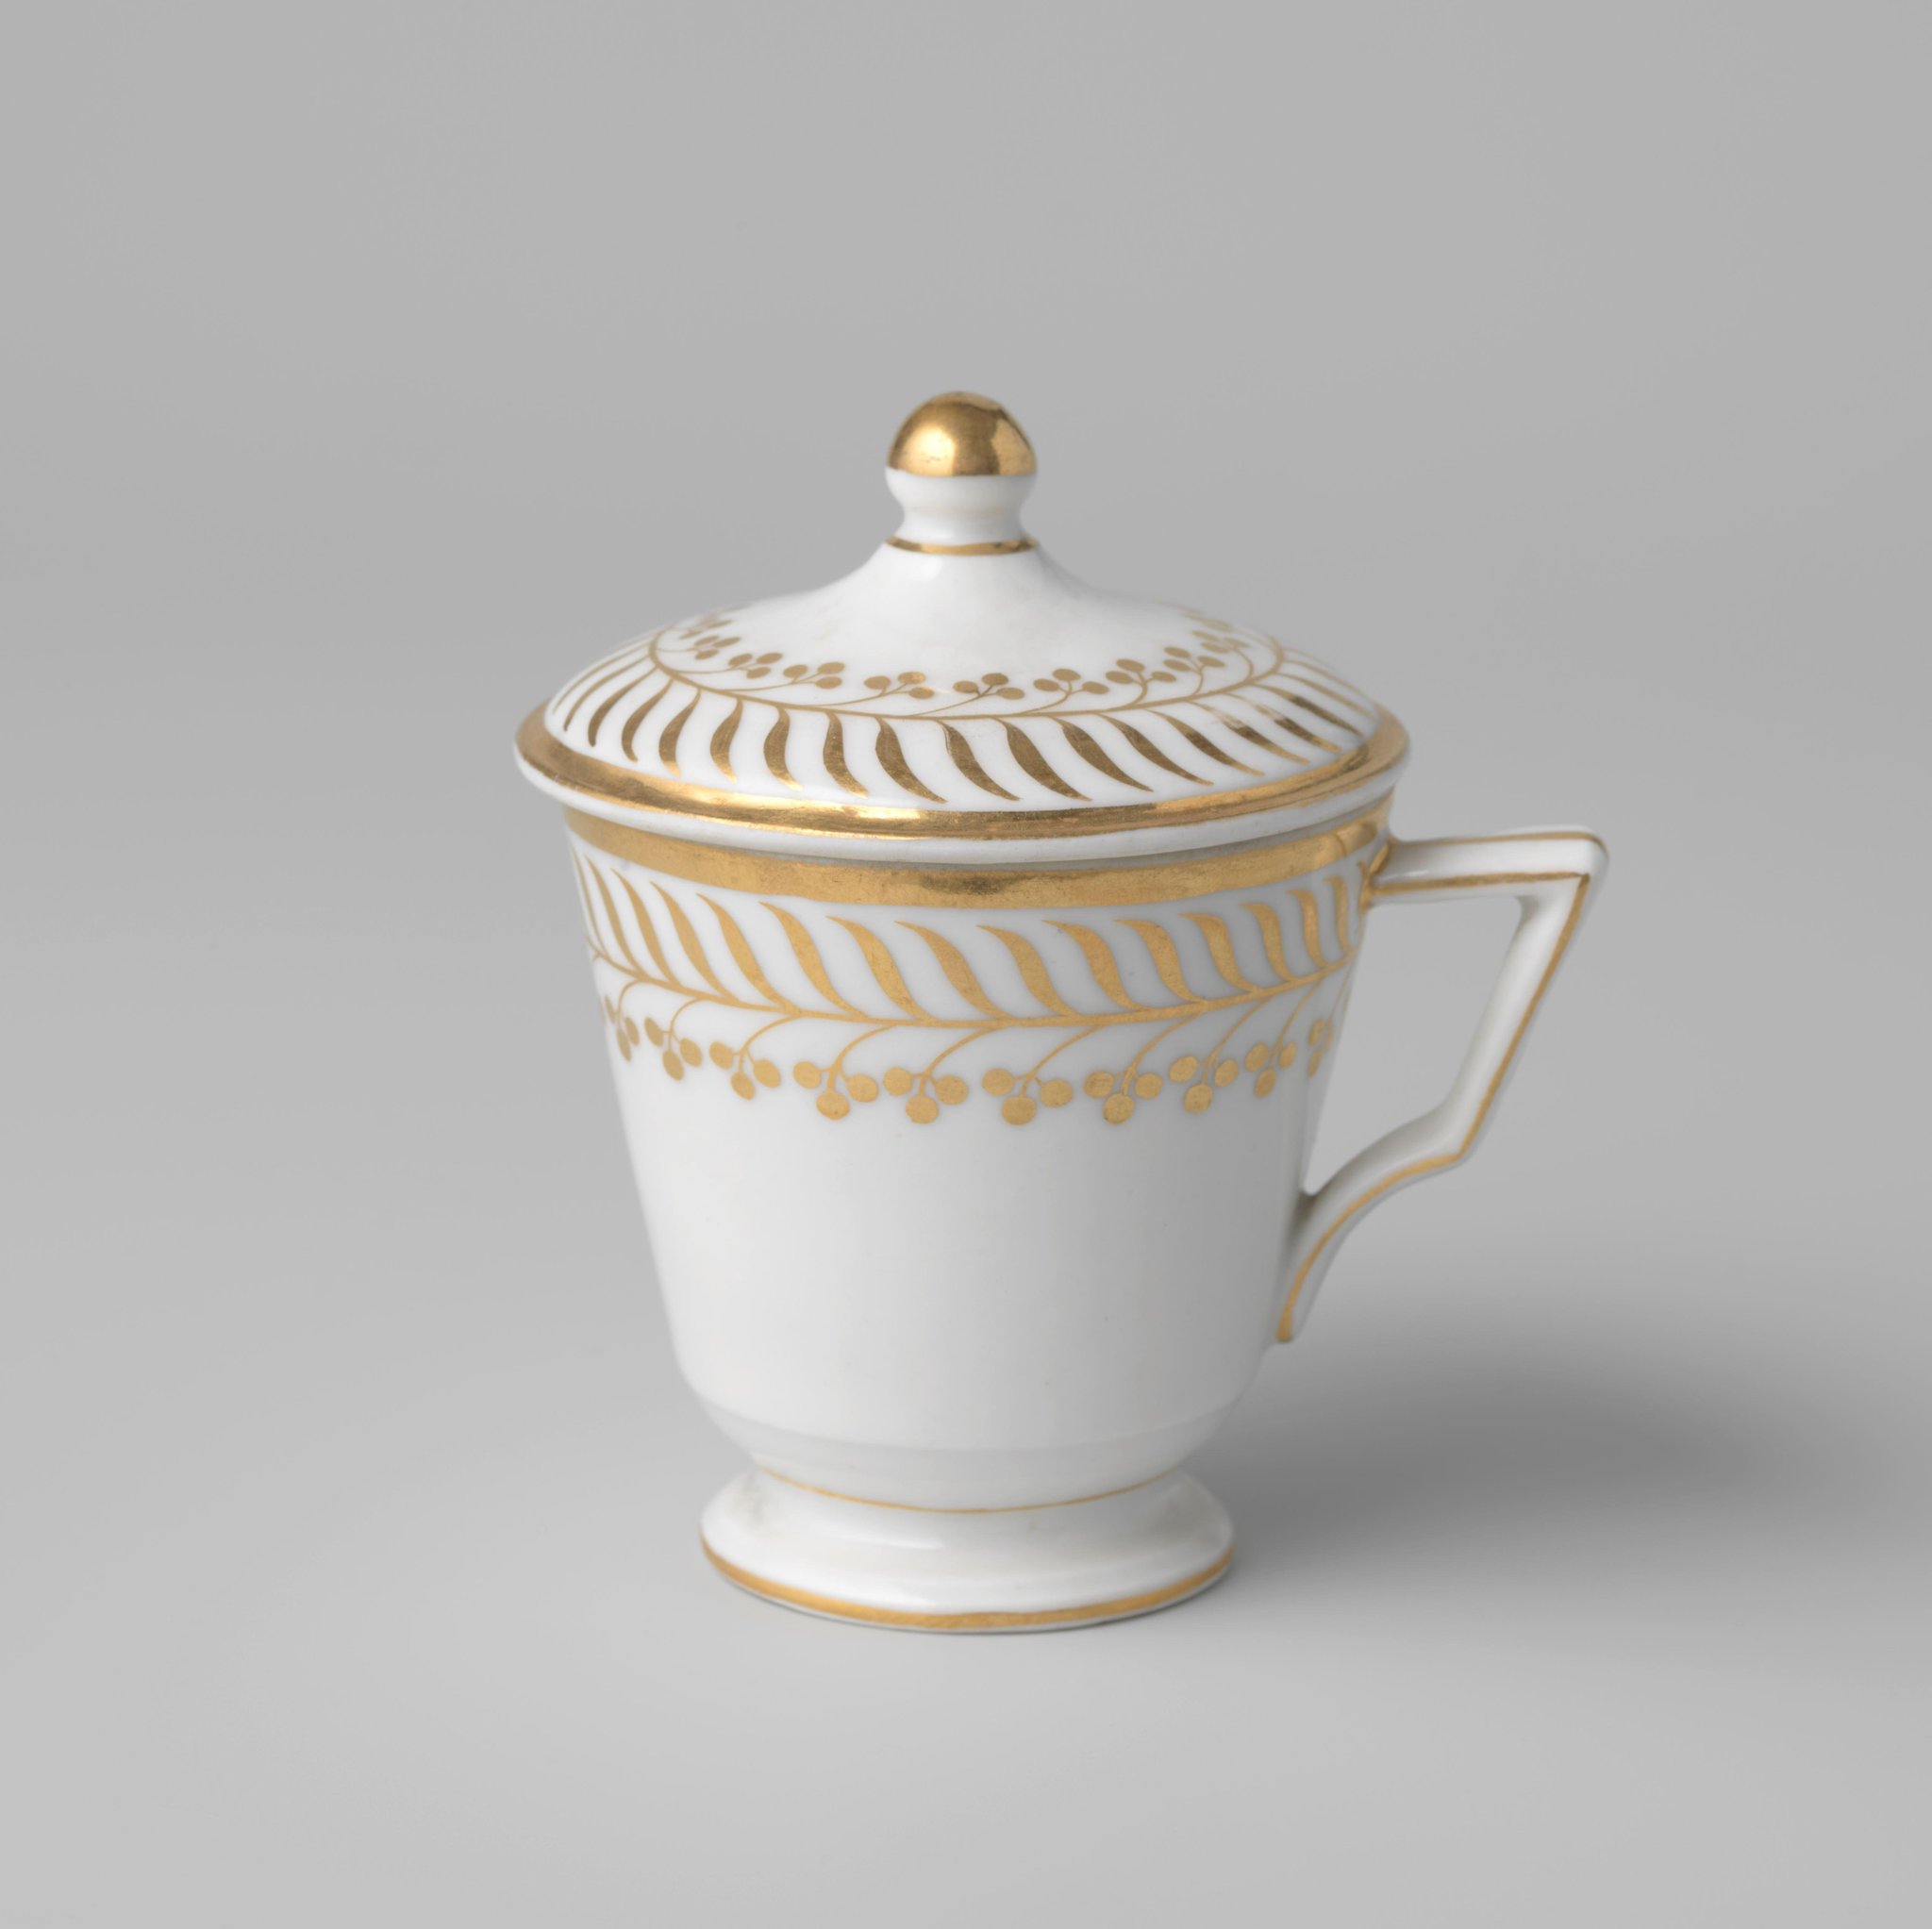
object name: service set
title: Covered cup (pot de crème) with stylized floral scrolls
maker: Anonymous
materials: glaze, gold, paint, porcelain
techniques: firing, forming, gilding, vitrification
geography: france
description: Crêmepot van porselein met oor. Versierd met gouden biezen en langs de randen beschilderd met een doorlopende tak met aan de ene zijde bladeren, aan de andere zijde steeds een tak met drie vruchten. Gemerkt met ingegrifte 1.